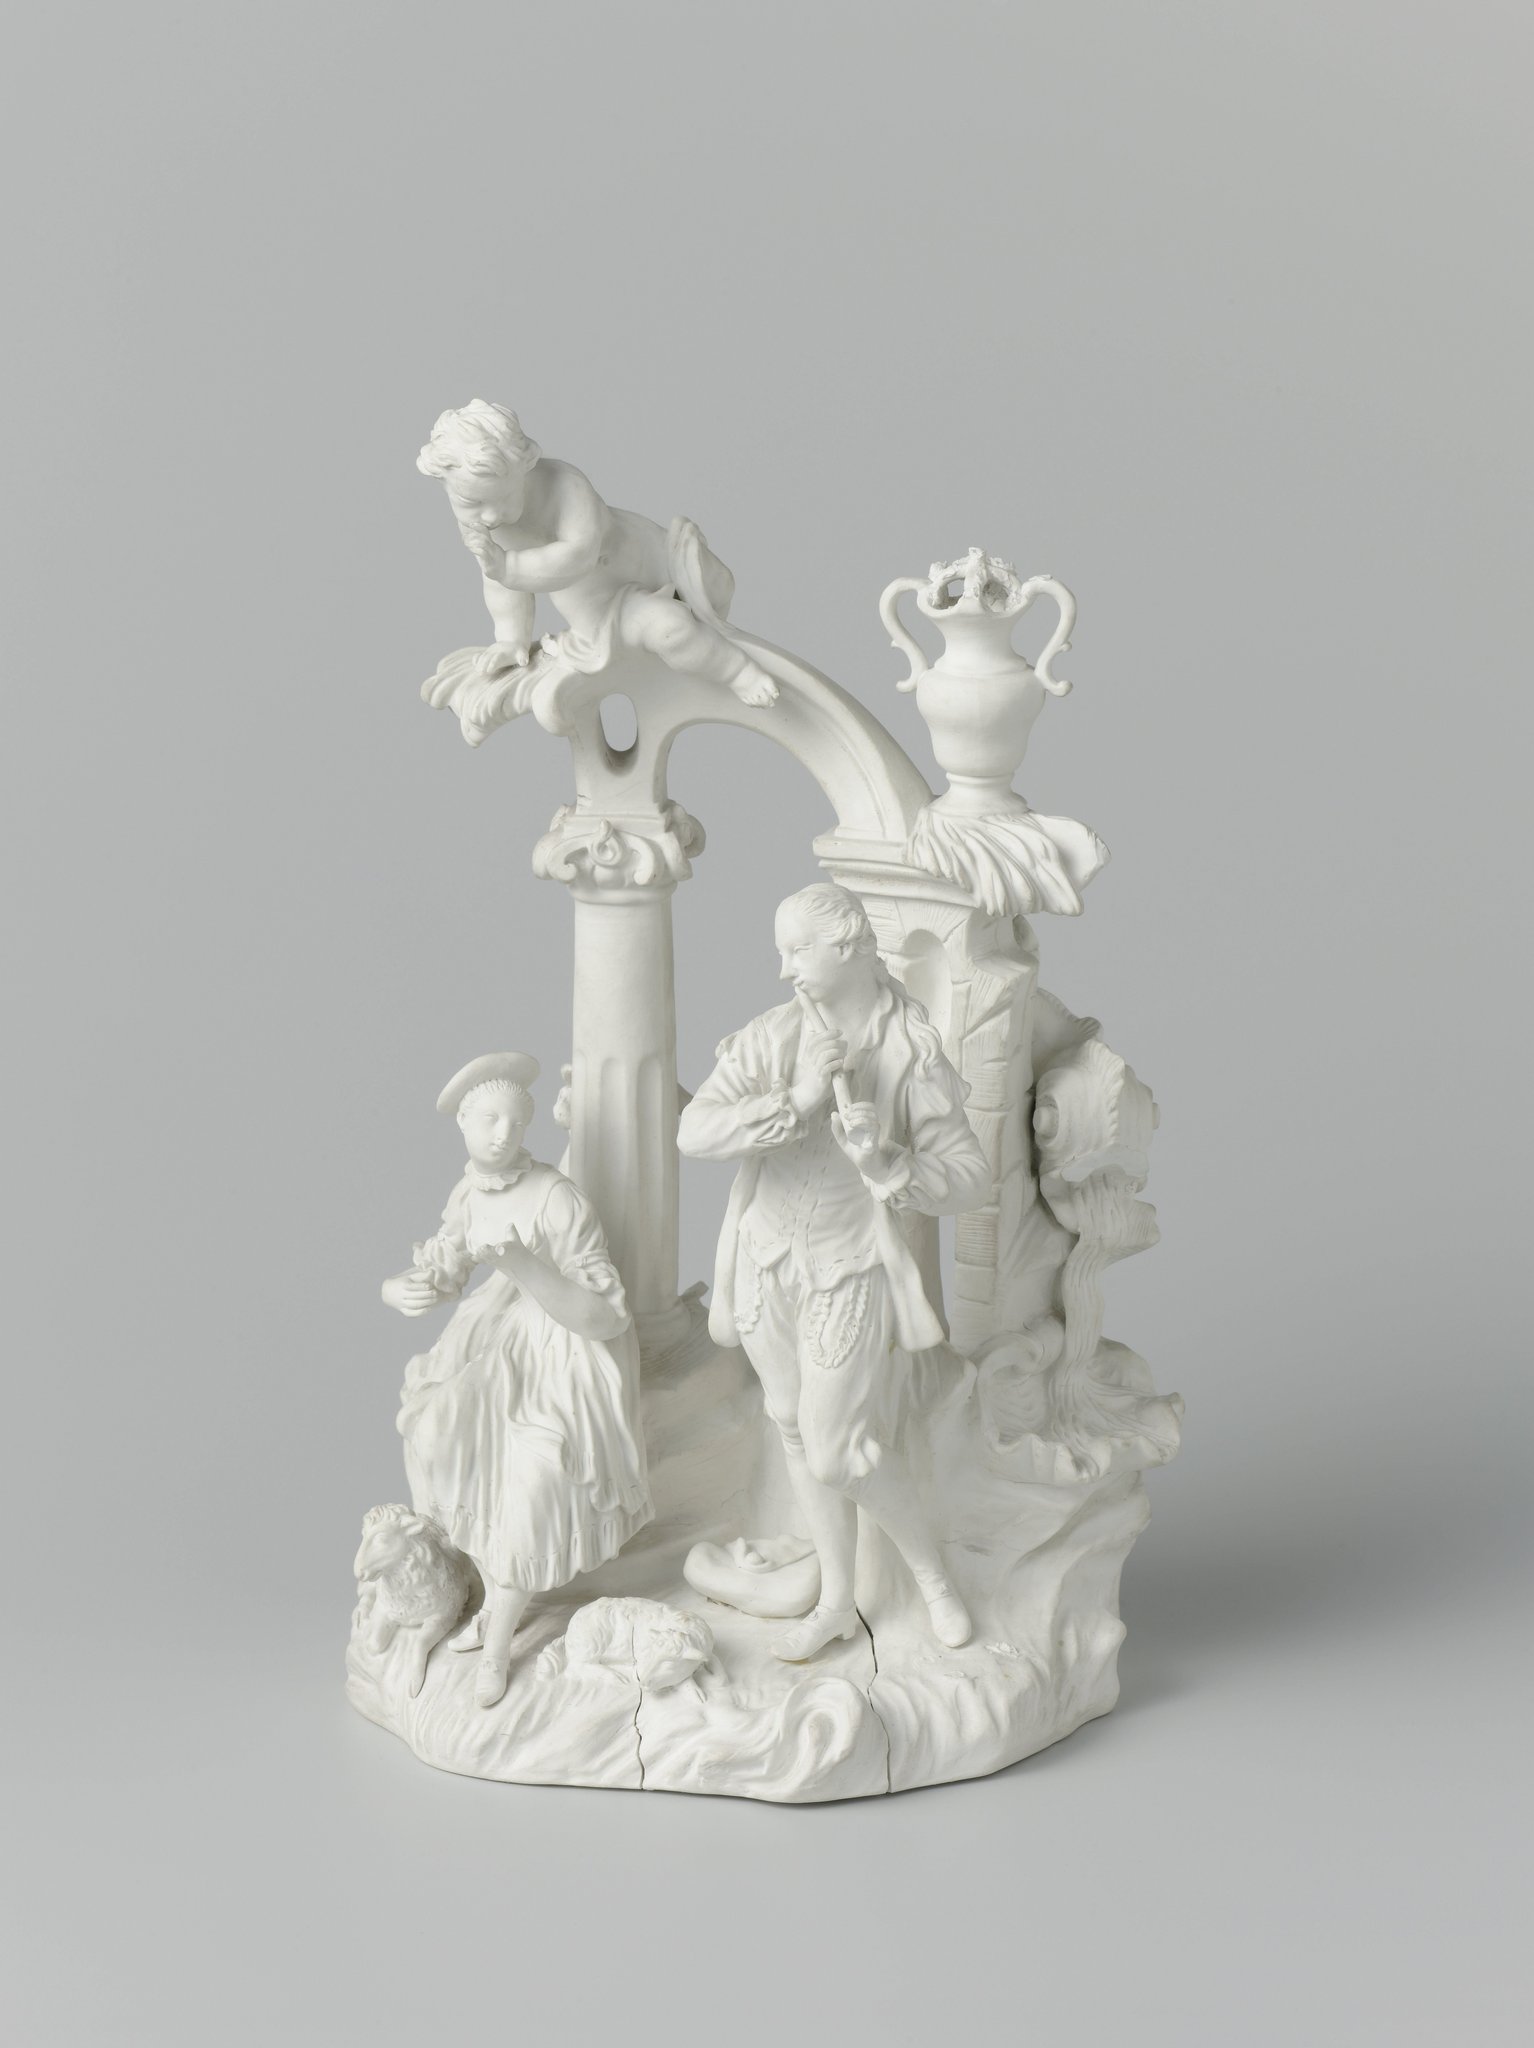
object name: sculpture group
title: Figure group of a shepherd, and shepherdess near a ruin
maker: nicolas-joseph gauron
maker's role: keramiekontwerper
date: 1764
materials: biscuit porcelain, material), porcelain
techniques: biscuit (porcelain, material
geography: weesp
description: This charming figure group is entirely Rococo in style. It was modelled by Nicolas Gauron, who had trained in Tournai and then worked in Weesp for a few years. Gauron’s modelling must have been a great success: the quality of his works was higher than what had been achieved in Weesp until then. The two figures were later also produced as individual statuettes.